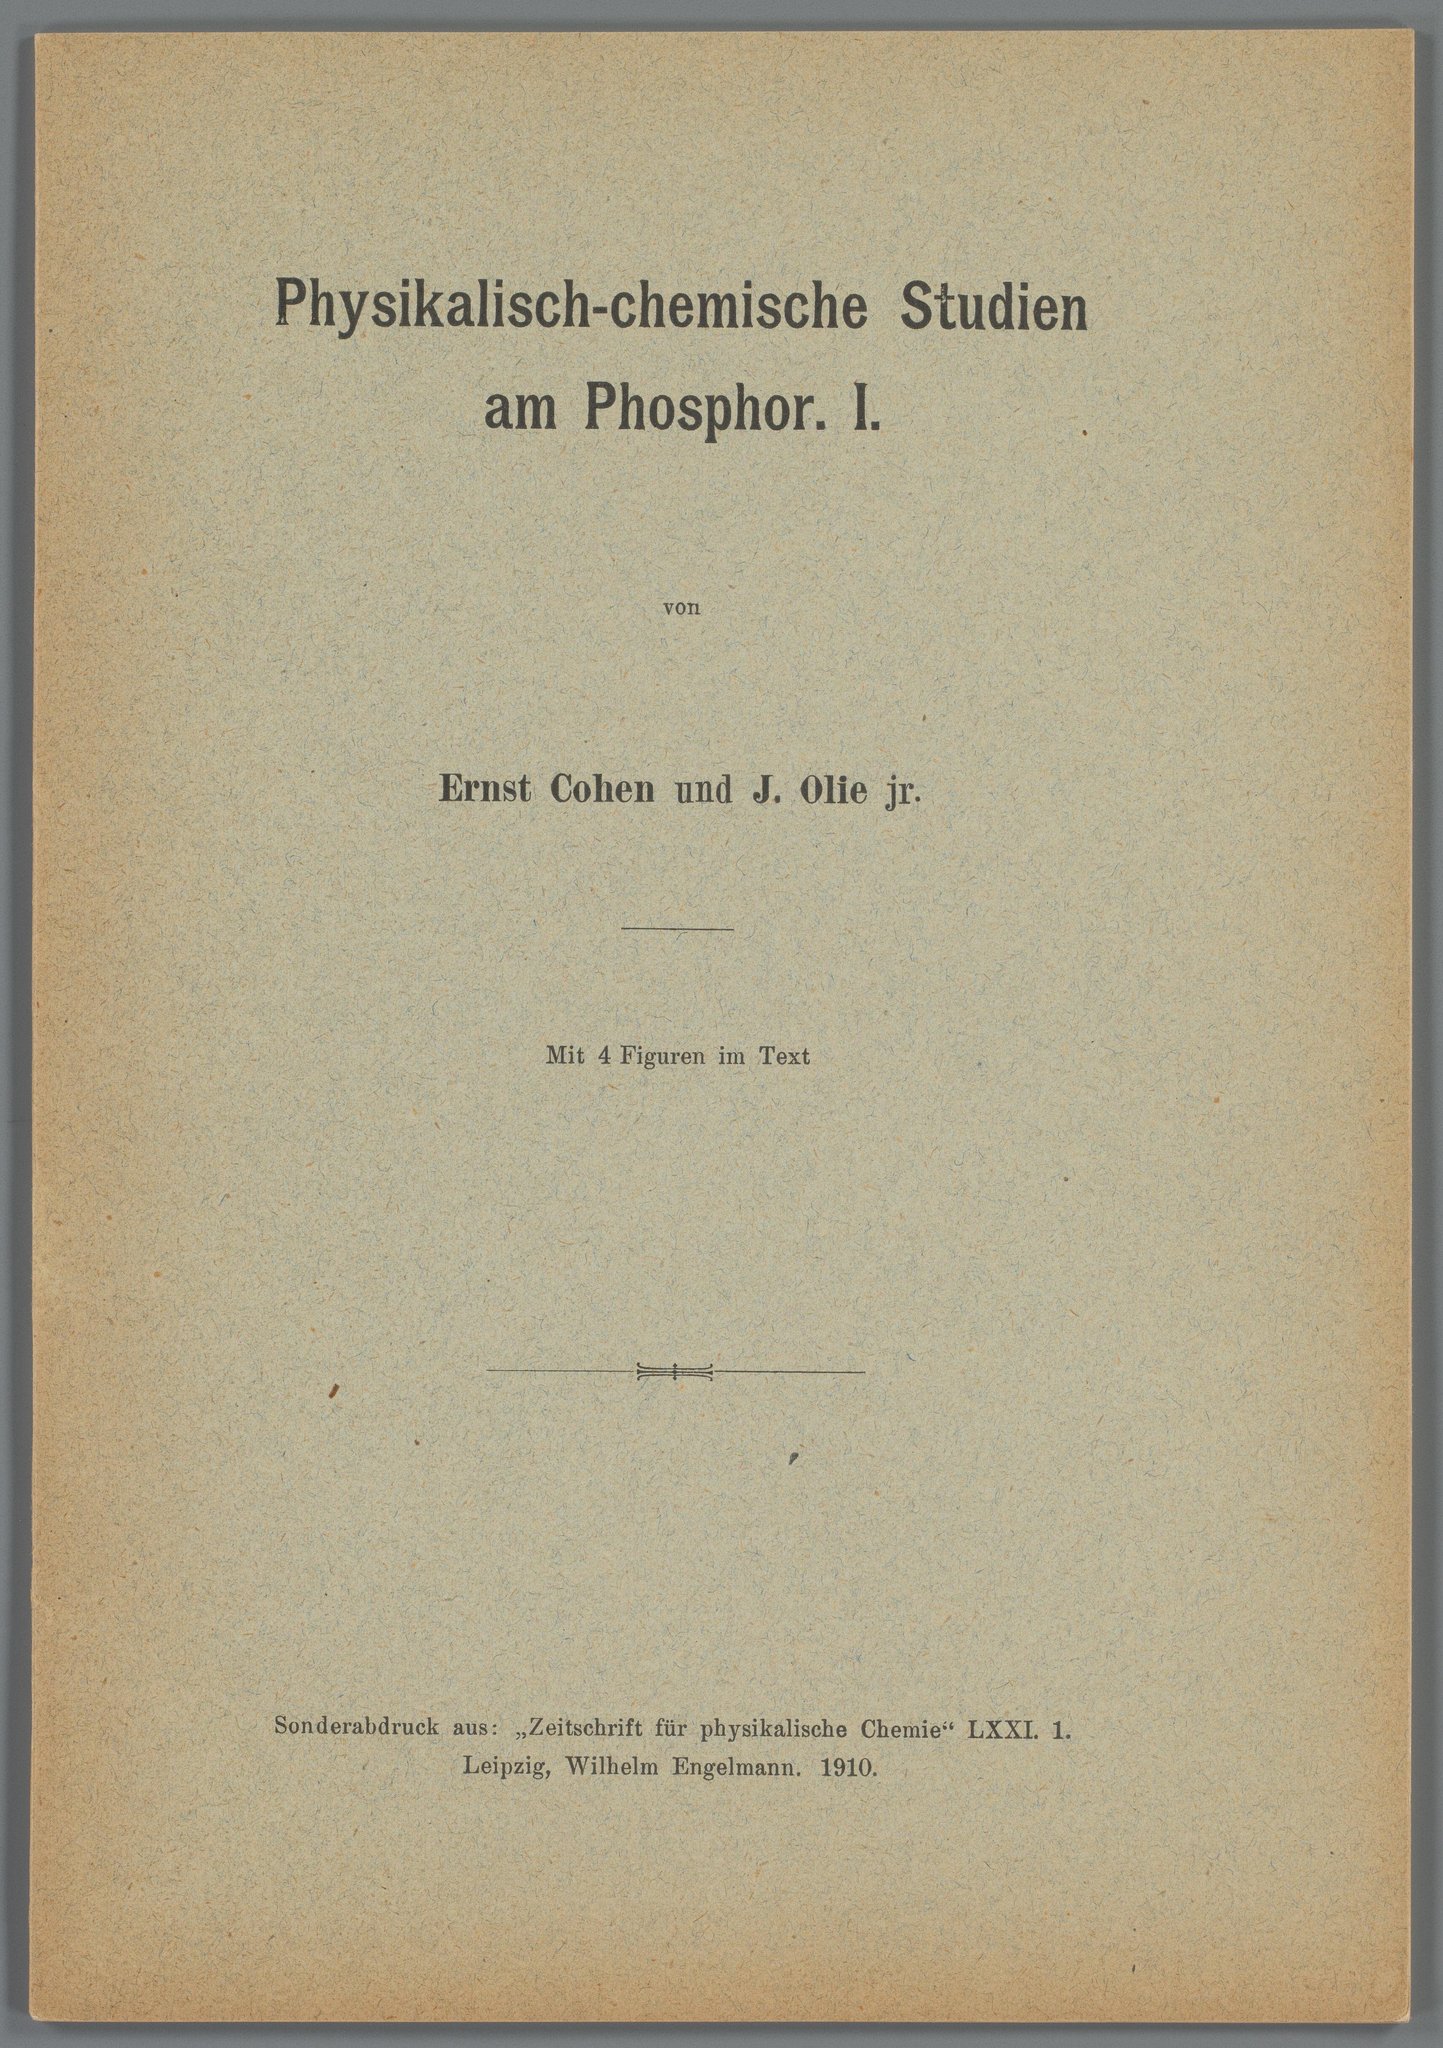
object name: offprint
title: Onderzoeksverslag over de allotrope modificatie van fosfor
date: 1910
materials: paper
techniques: letterpress printing, printing block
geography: leipzig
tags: printed matter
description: Overdruk uit het Zeitschrift für physikalische Chemie LXXI 1.